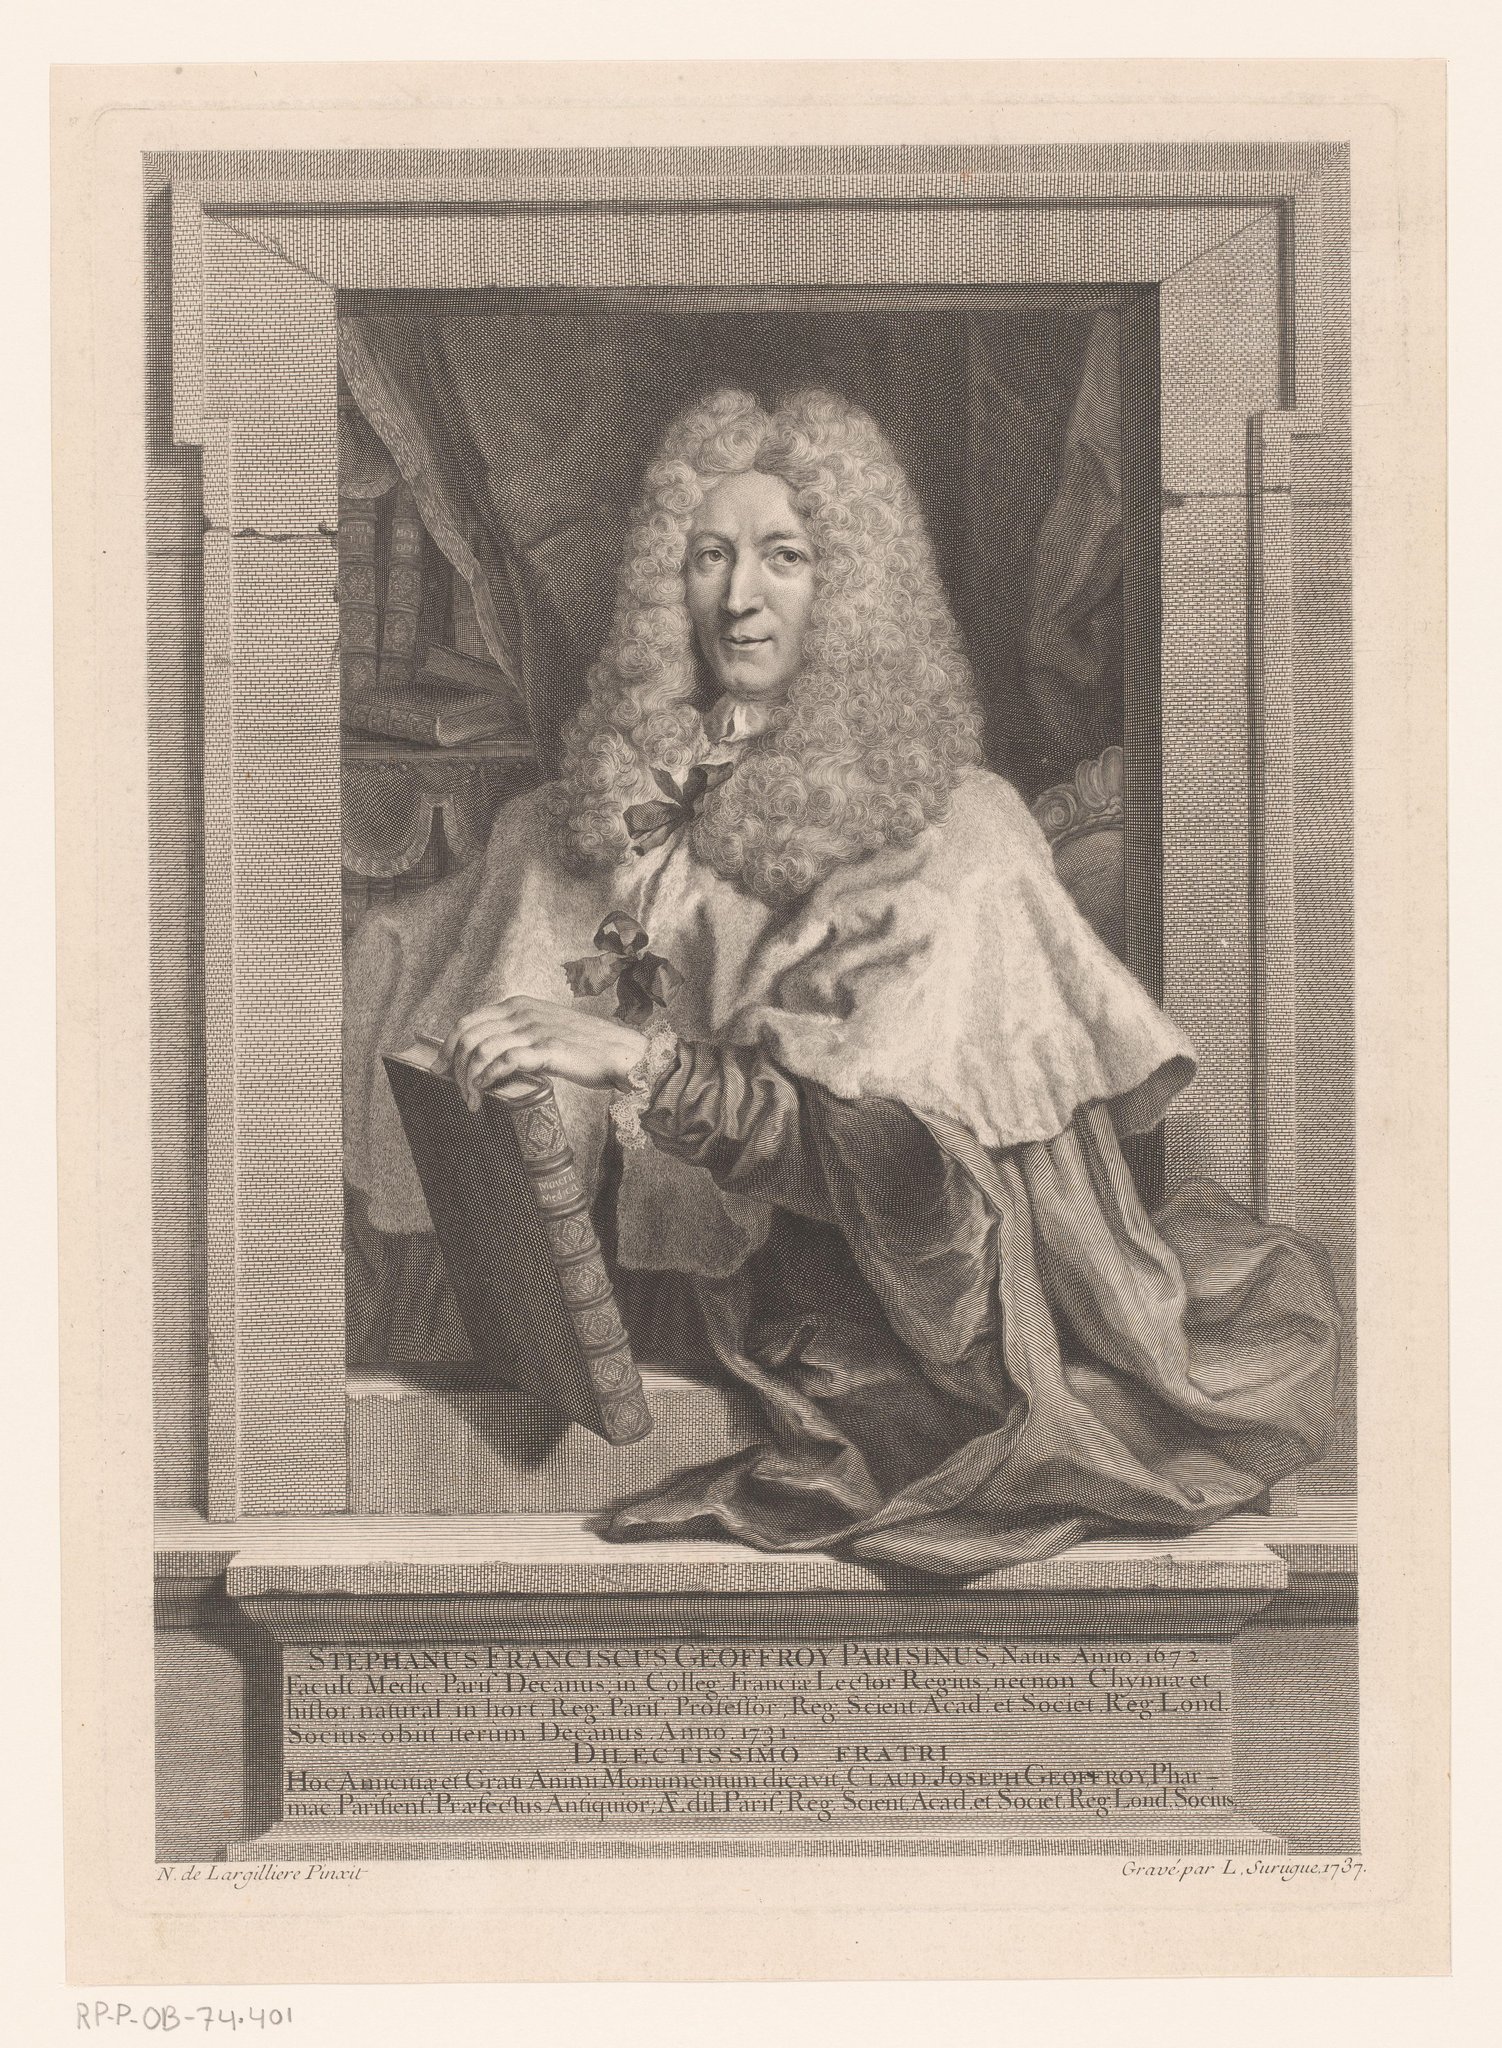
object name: print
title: Portret van Stephanus Franciscus Geoffroy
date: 1737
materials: paper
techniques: engraving, etching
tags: historical persons, physician, doctor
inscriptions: collector's mark: Lugt 2228